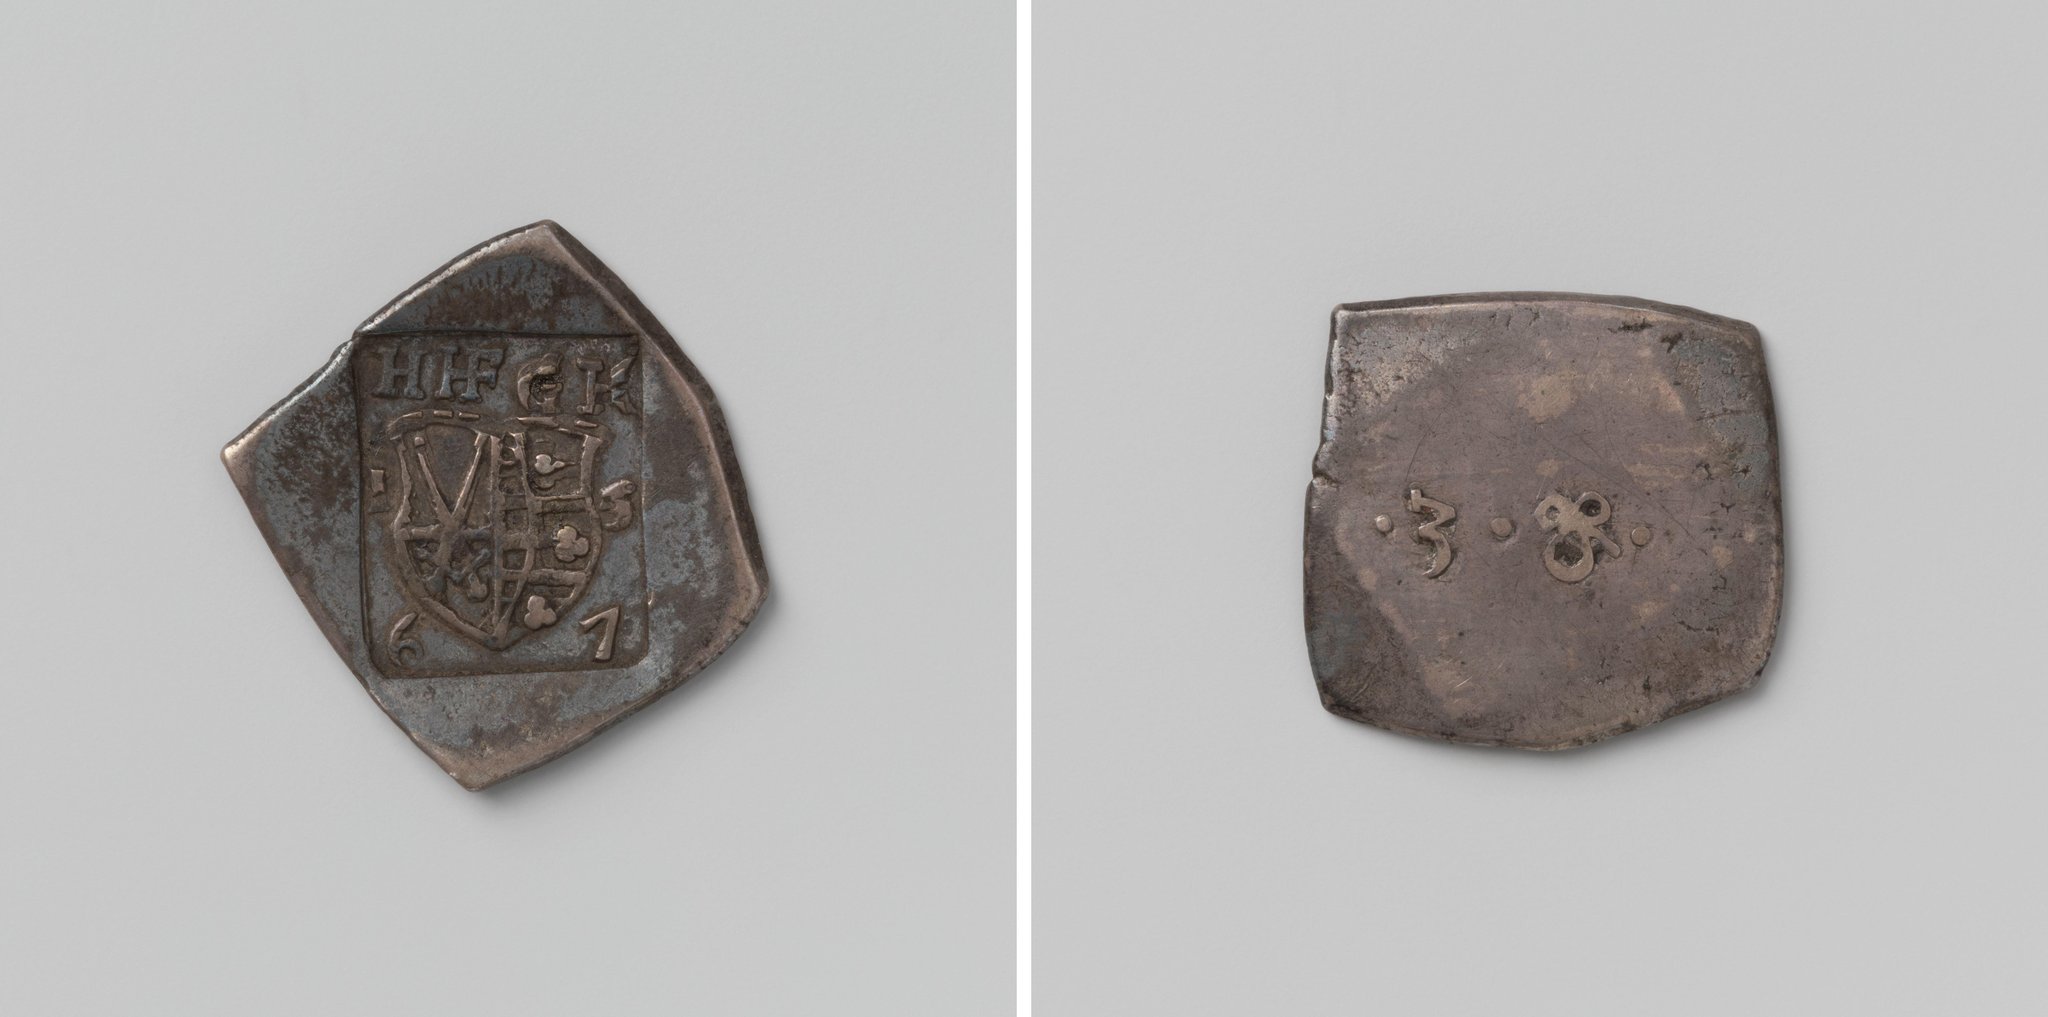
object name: siege coin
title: Drie groschen, noodmunt uit Gotha van Johan Frederik II hertog van Saksen, geslagen tijdens het beleg door de troepen van keurvorst August van Saksen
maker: Anonymous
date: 1567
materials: silver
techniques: striking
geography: gotha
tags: dresden, keurvorst, keurvorst van saksen augustus, hertog, johan frederik ii (hertog van saksen), gotha, beleg van gotha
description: ruitvormige noodmunt met gat erin. Voorzijde: een rechthoekige stempel: letters H, HF, G en K boven wapenschild tussen jaartal. Keerzijde: opschrift 3 gr